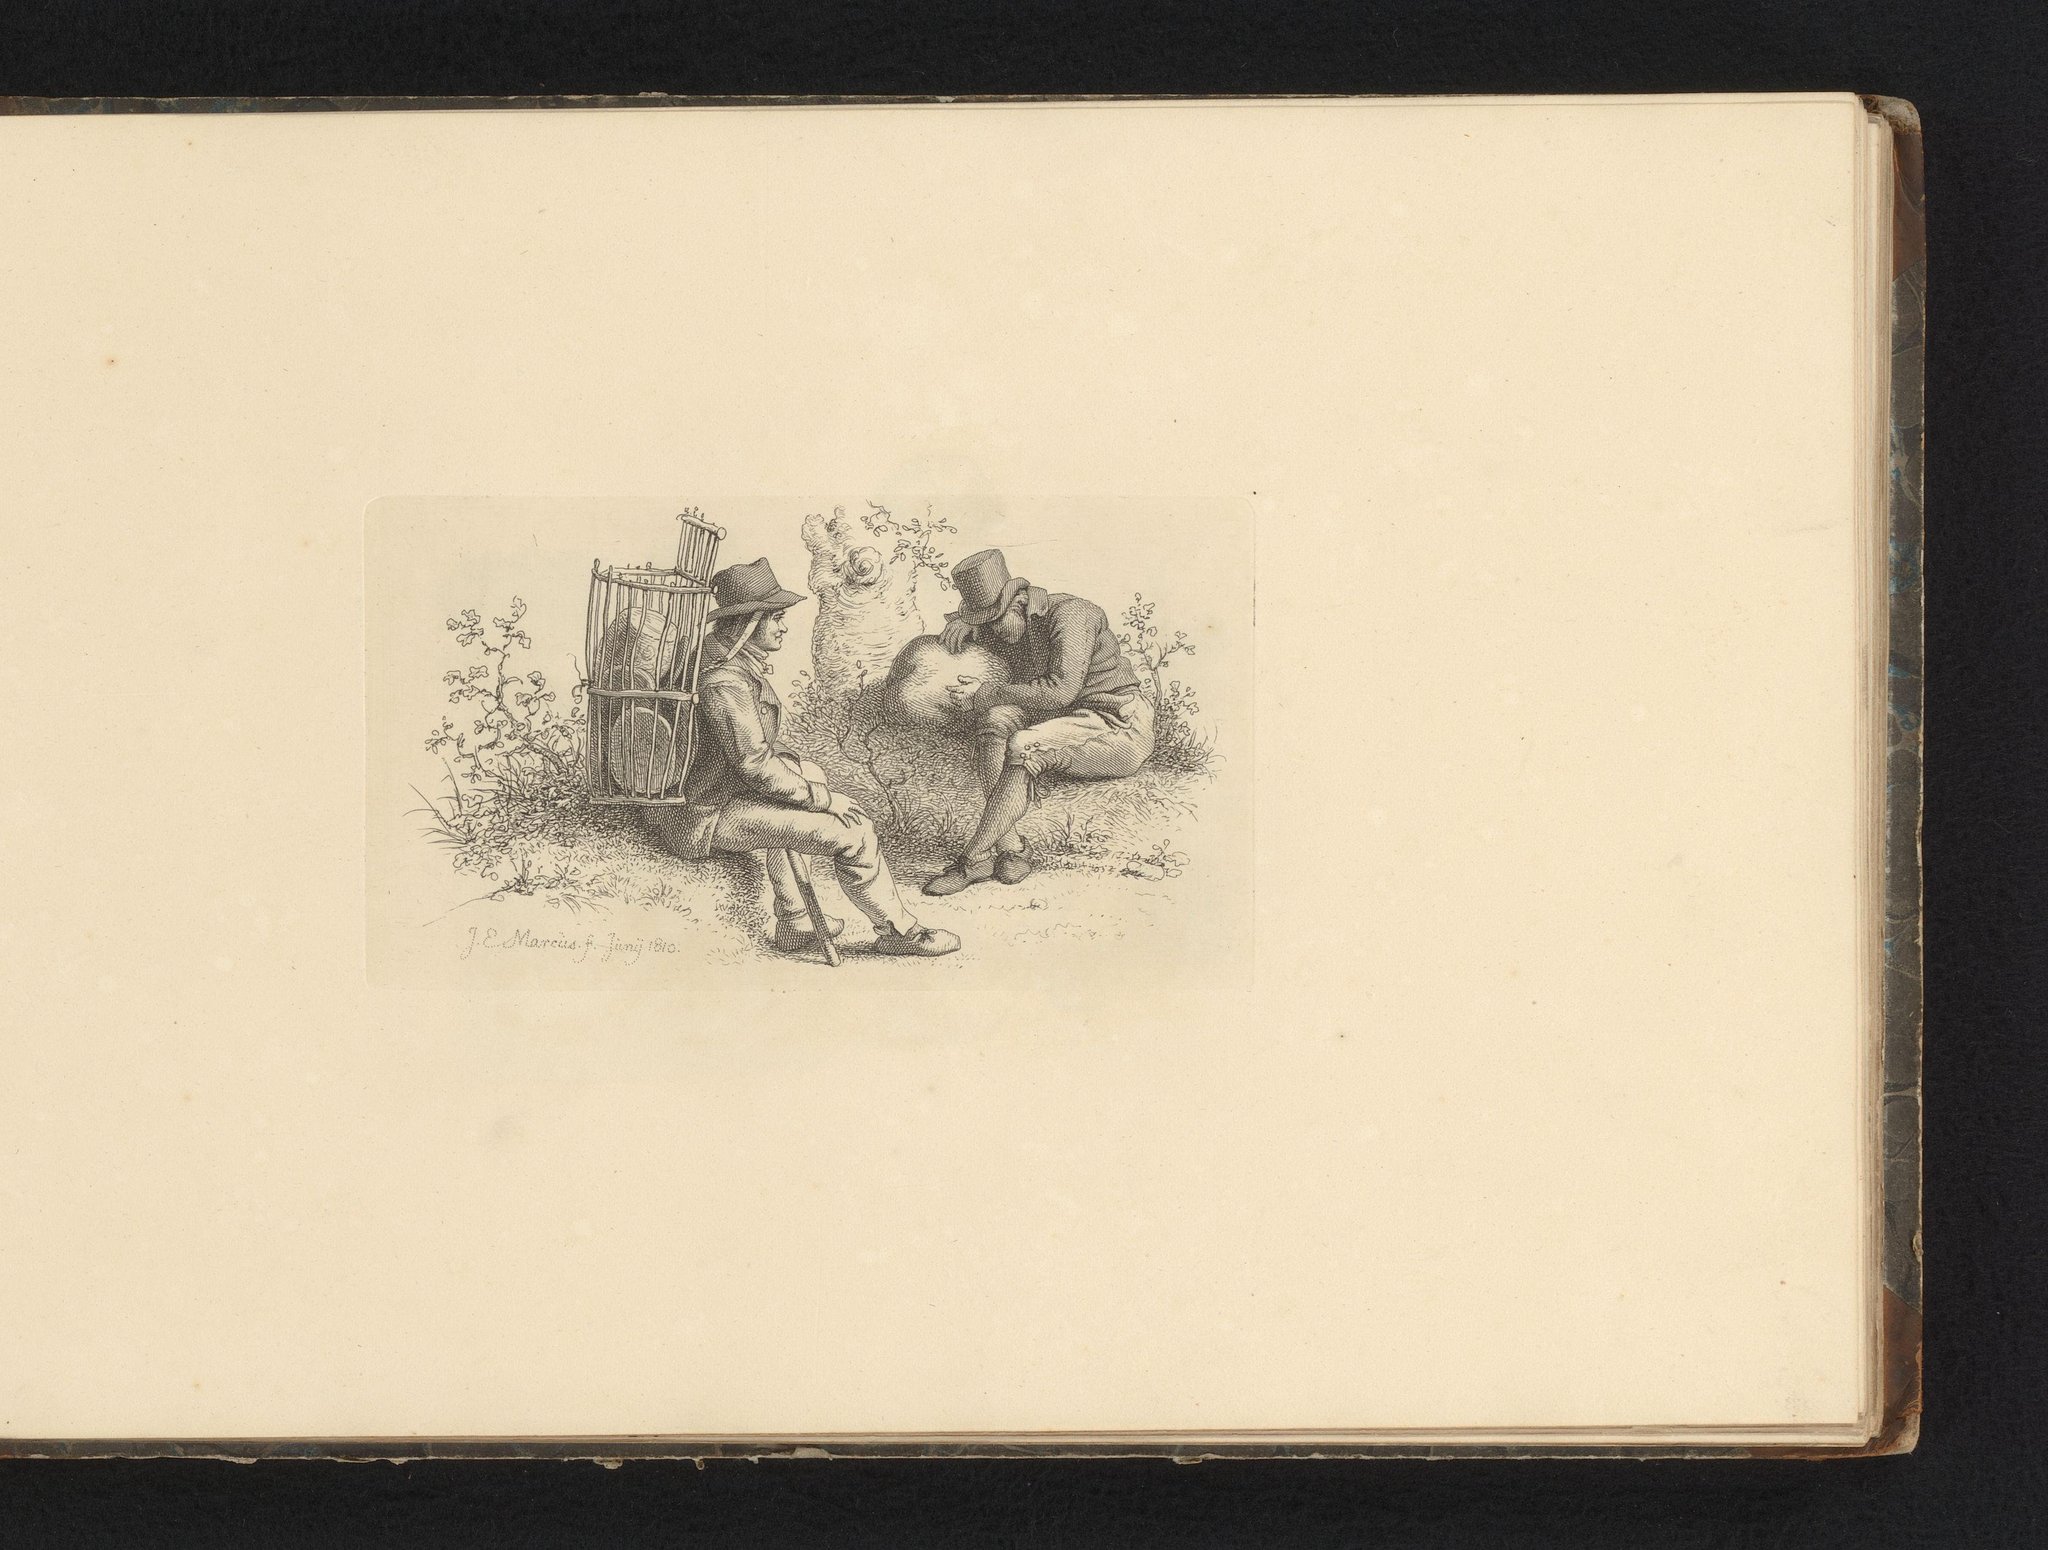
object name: album leaf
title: Studiebeelden en fragmenten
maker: jacob ernst marcus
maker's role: draughtsman, print maker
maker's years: 1774-1826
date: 1806-1810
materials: paper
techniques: etching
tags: container made of plant material other than wood: basket, wandering or travelling merchant, sitting on an elevation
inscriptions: date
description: Deze prent maakt deel uit van een album.